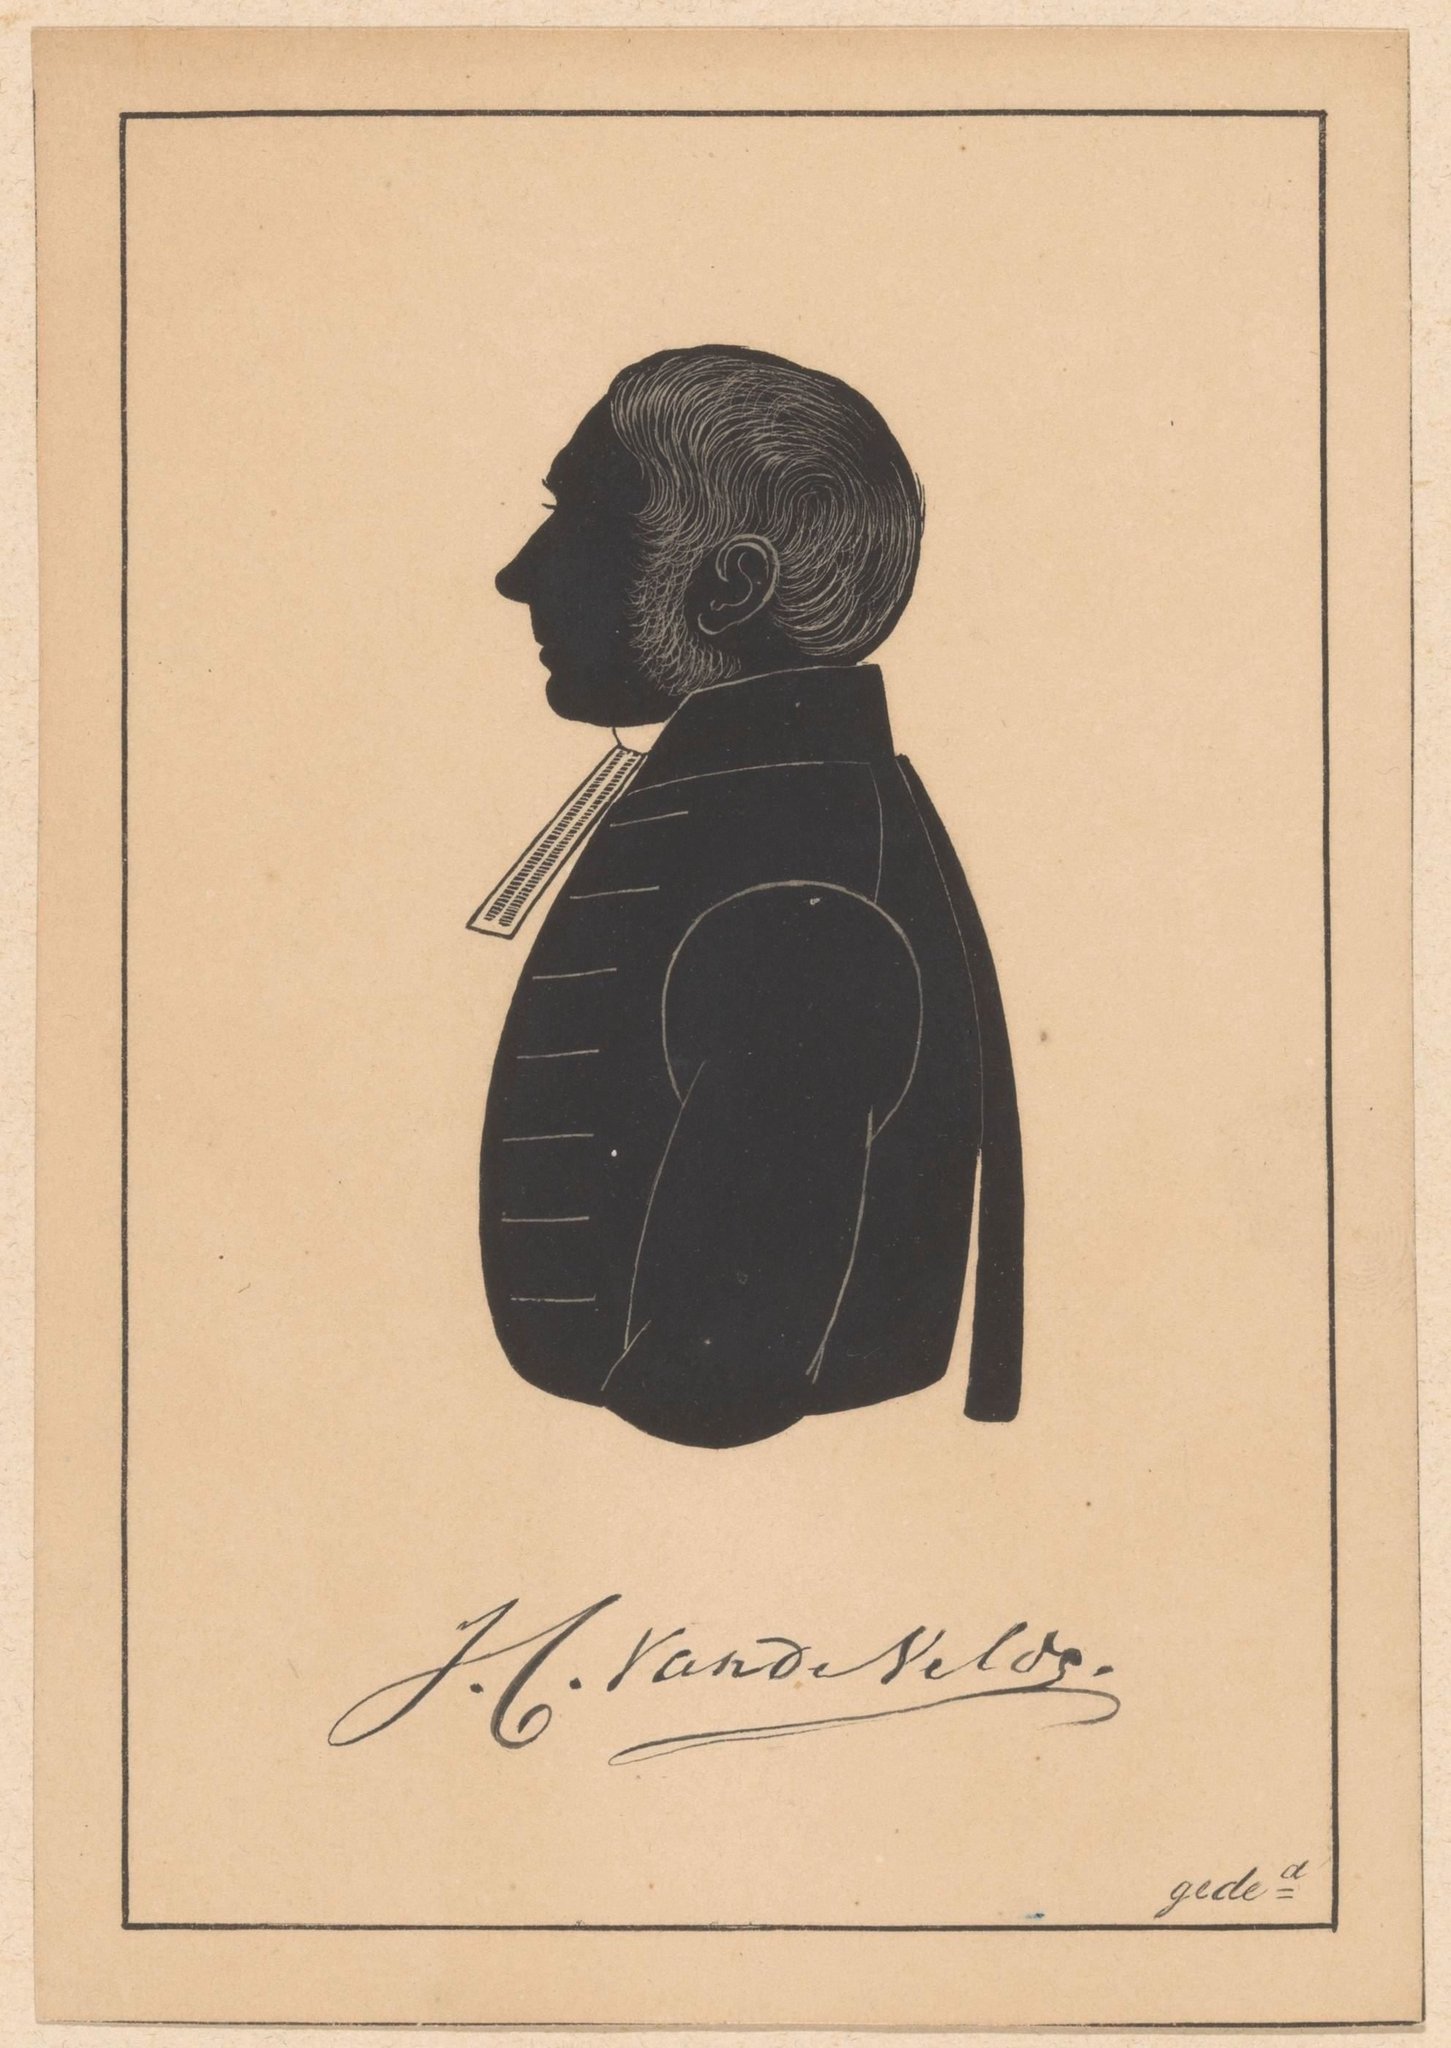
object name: print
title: Silhouetportret van Jacob Carel van de Velde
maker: pieter barbiers (iv)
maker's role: painter, print maker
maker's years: 1798-1848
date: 1809-1848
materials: paper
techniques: hand coloring, lithograph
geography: netherlands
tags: amsterdam, historical persons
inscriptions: : ‘Gede.d’, collector's mark: Lugt 2228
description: Onder het portret de signatuur van de geportretteerde.